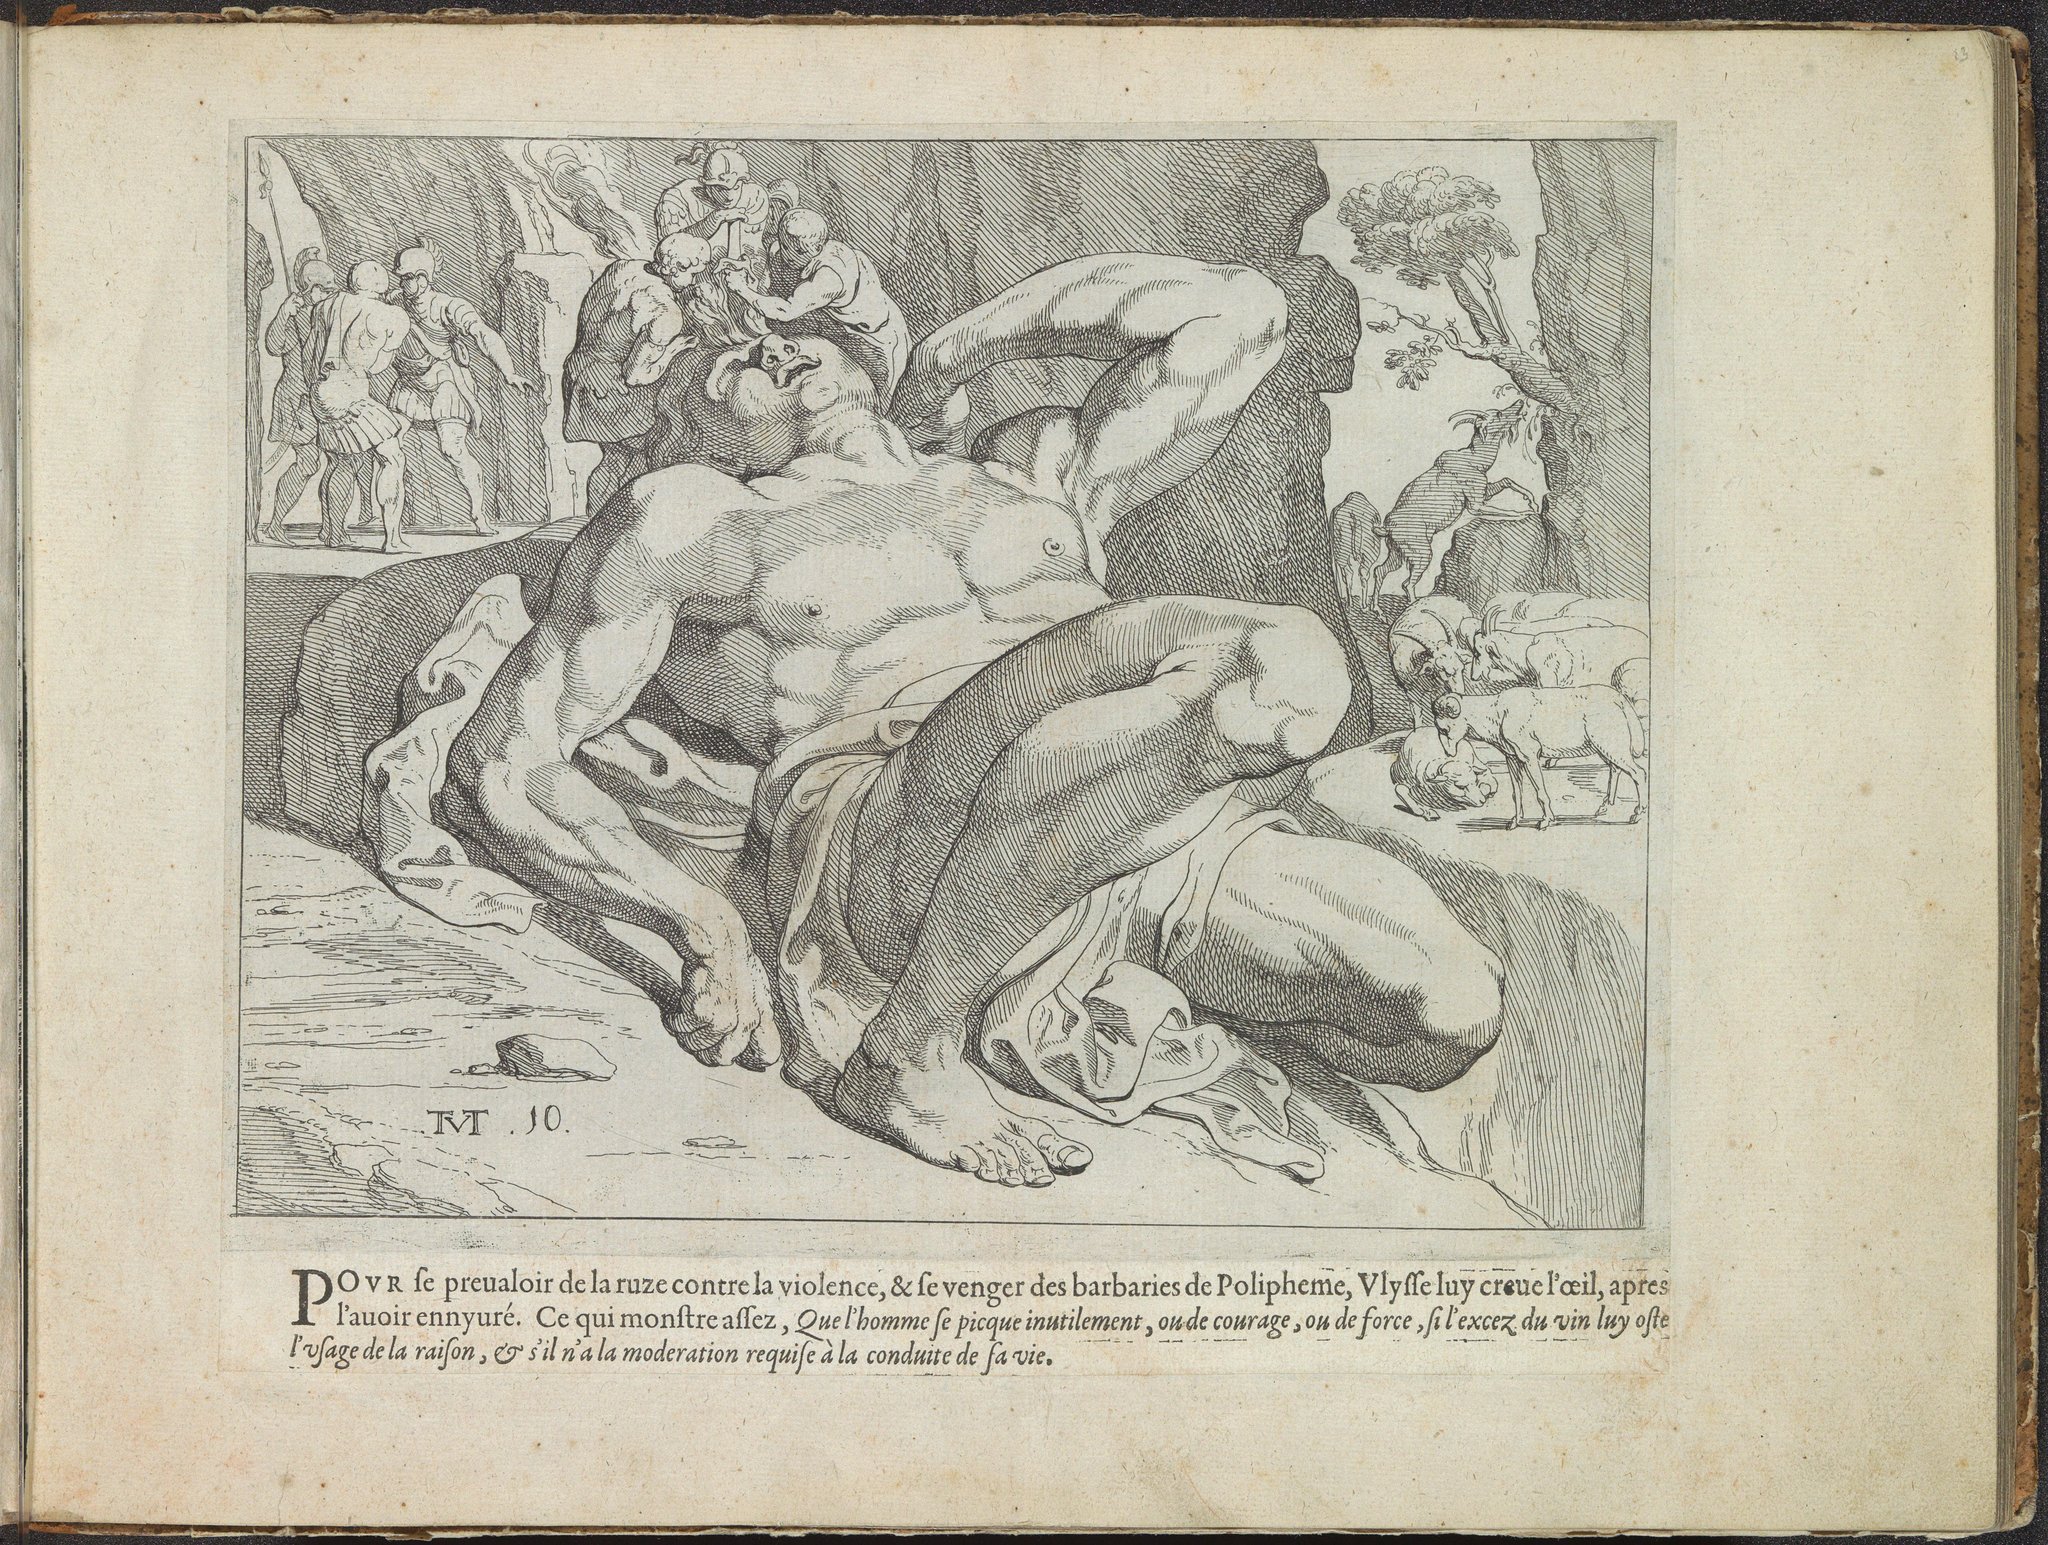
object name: album leaf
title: Blindmaking van Polyphemus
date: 1633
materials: paper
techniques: engraving, etching, letterpress printing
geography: paris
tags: polyphemus is blinded with a pointed stake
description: Odysseus en zijn krijgslieden steken het oog van de reus Polyphemus uit. De prent maakt deel uit van een album.